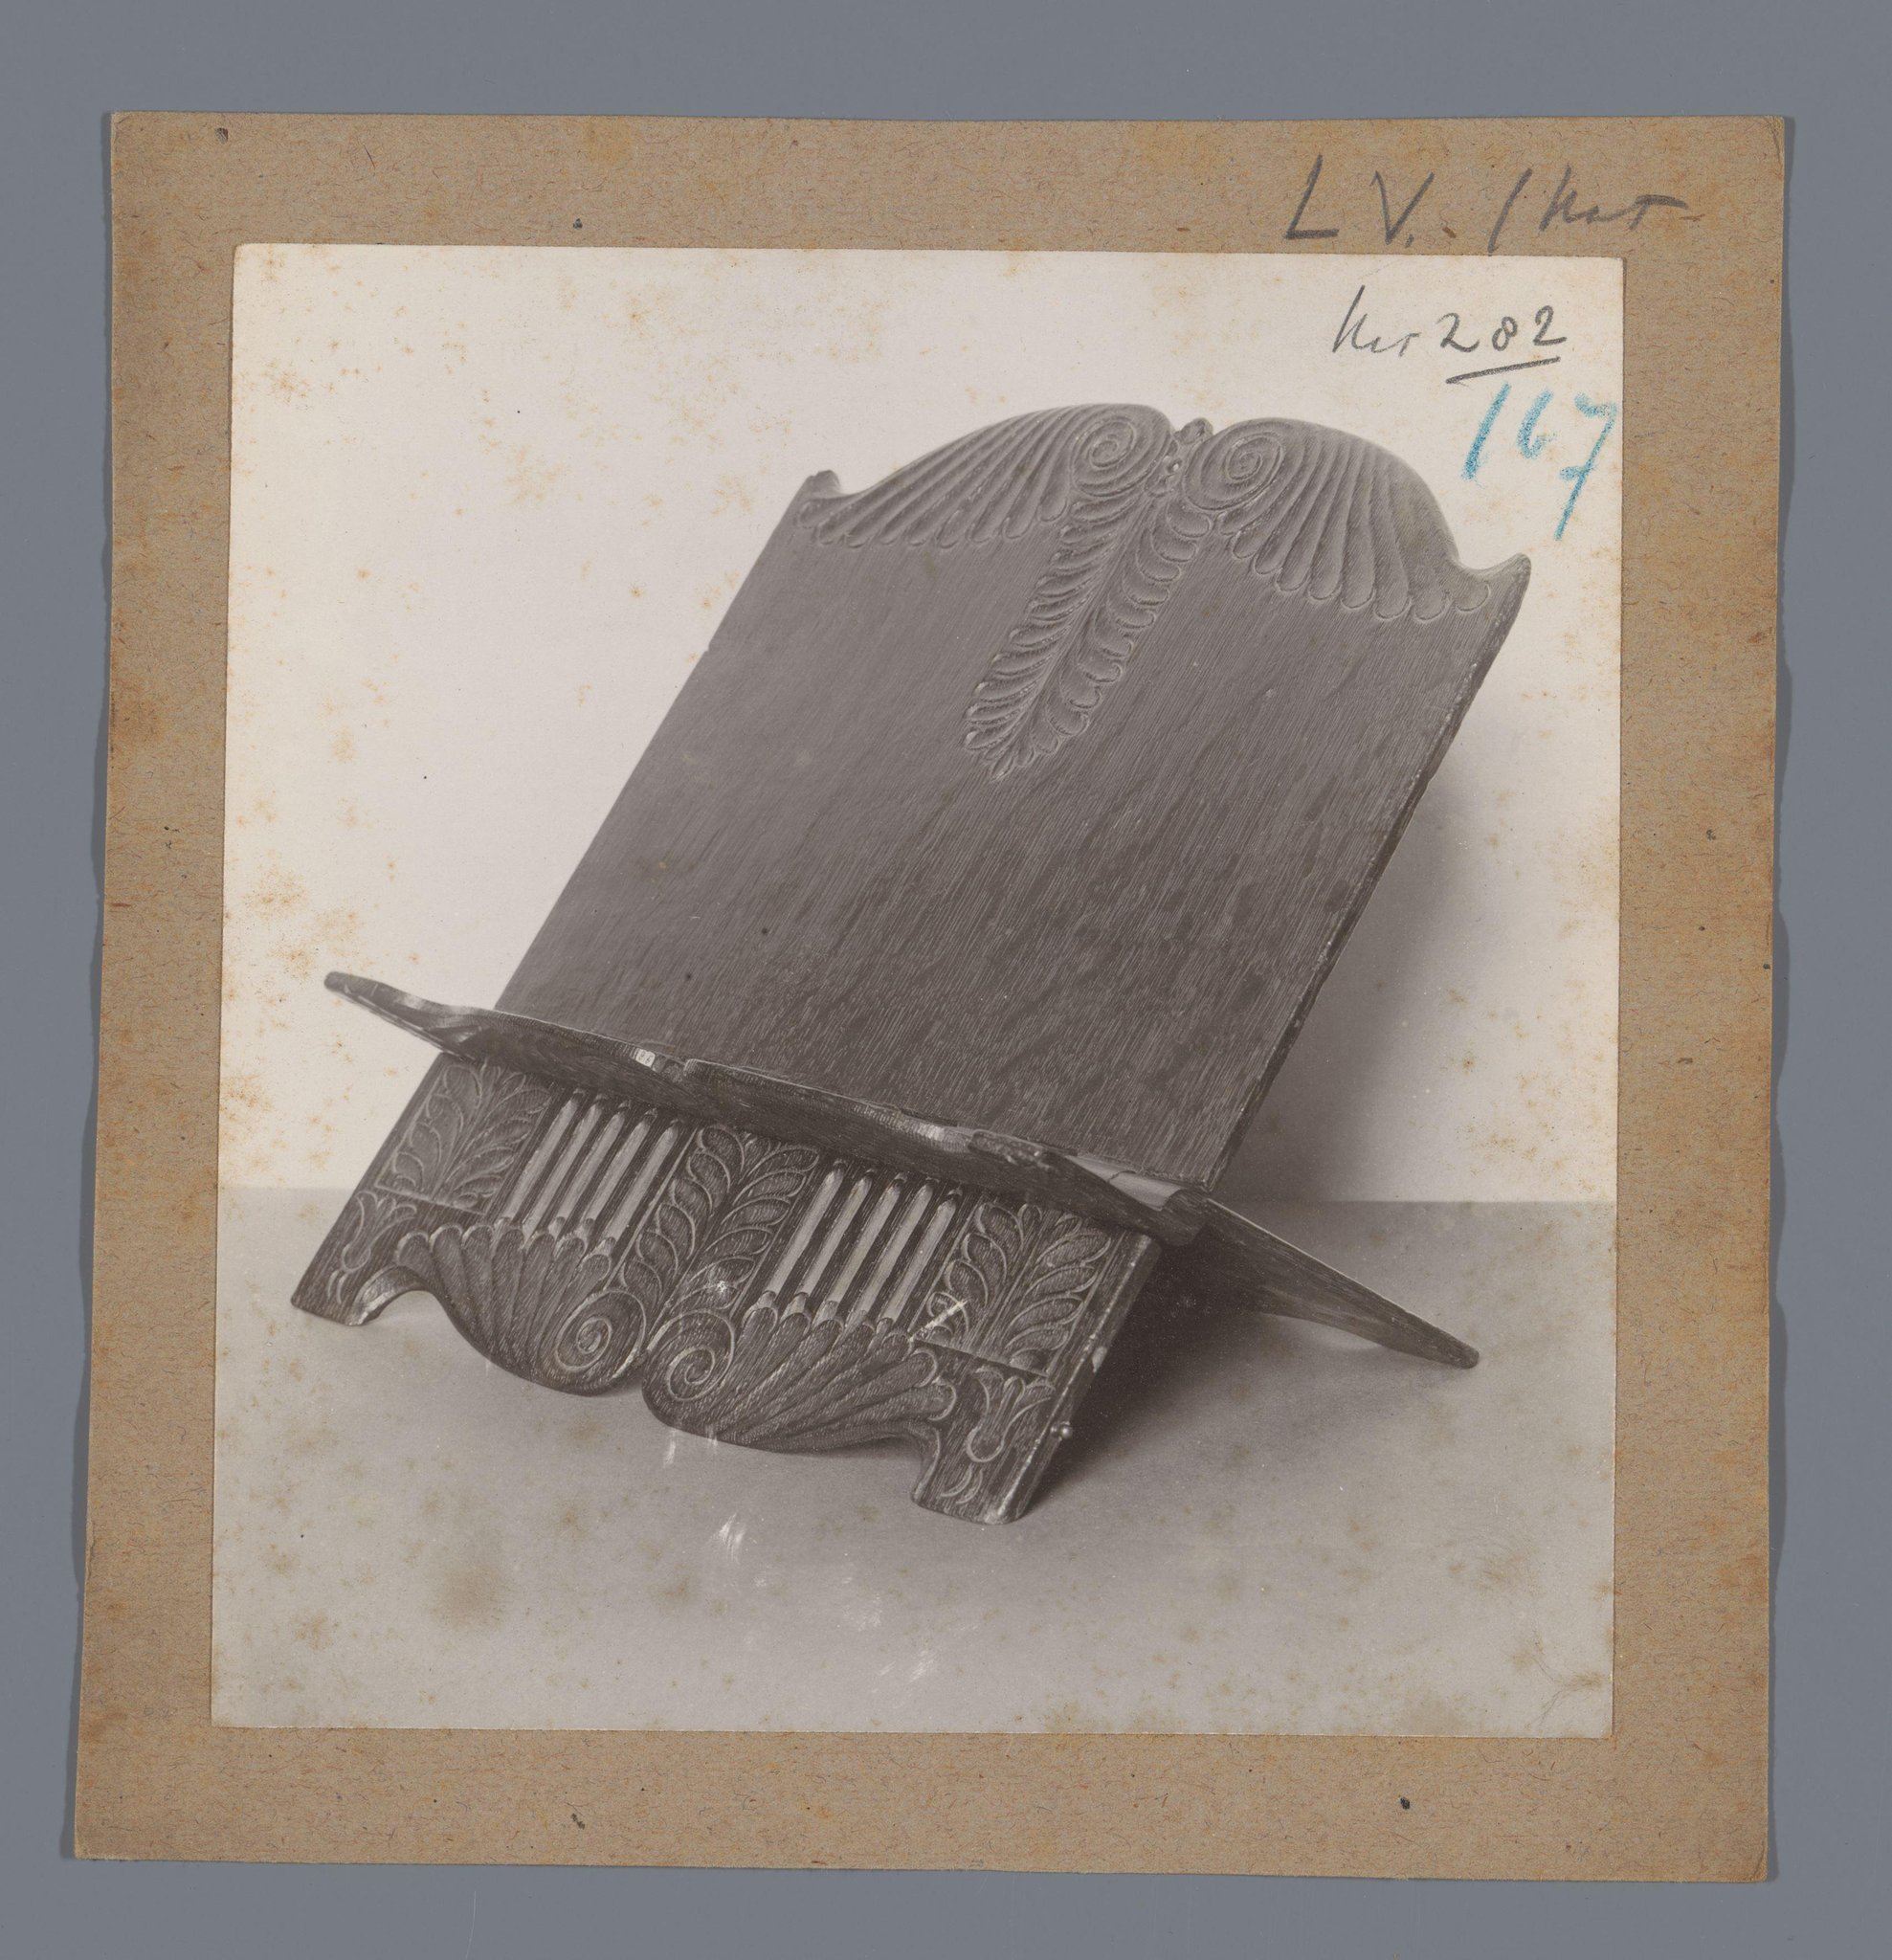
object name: photograph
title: Houten standaard of kruk gedecoreerd met een plantmotief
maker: Anonymous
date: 1875-1900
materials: photographic support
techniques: matte daylight collodion silver print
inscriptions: collector's mark: ‘Kunstnijverheidschool Quellinus Amsterdam Frans Halsstraat 14.’, collector's mark: ‘Instituut voor kunst-nijverheidsonderwijs Gabriël Metsustraat No. 16, Amsterdam’, inscription: ‘LV. Kat 282 167’